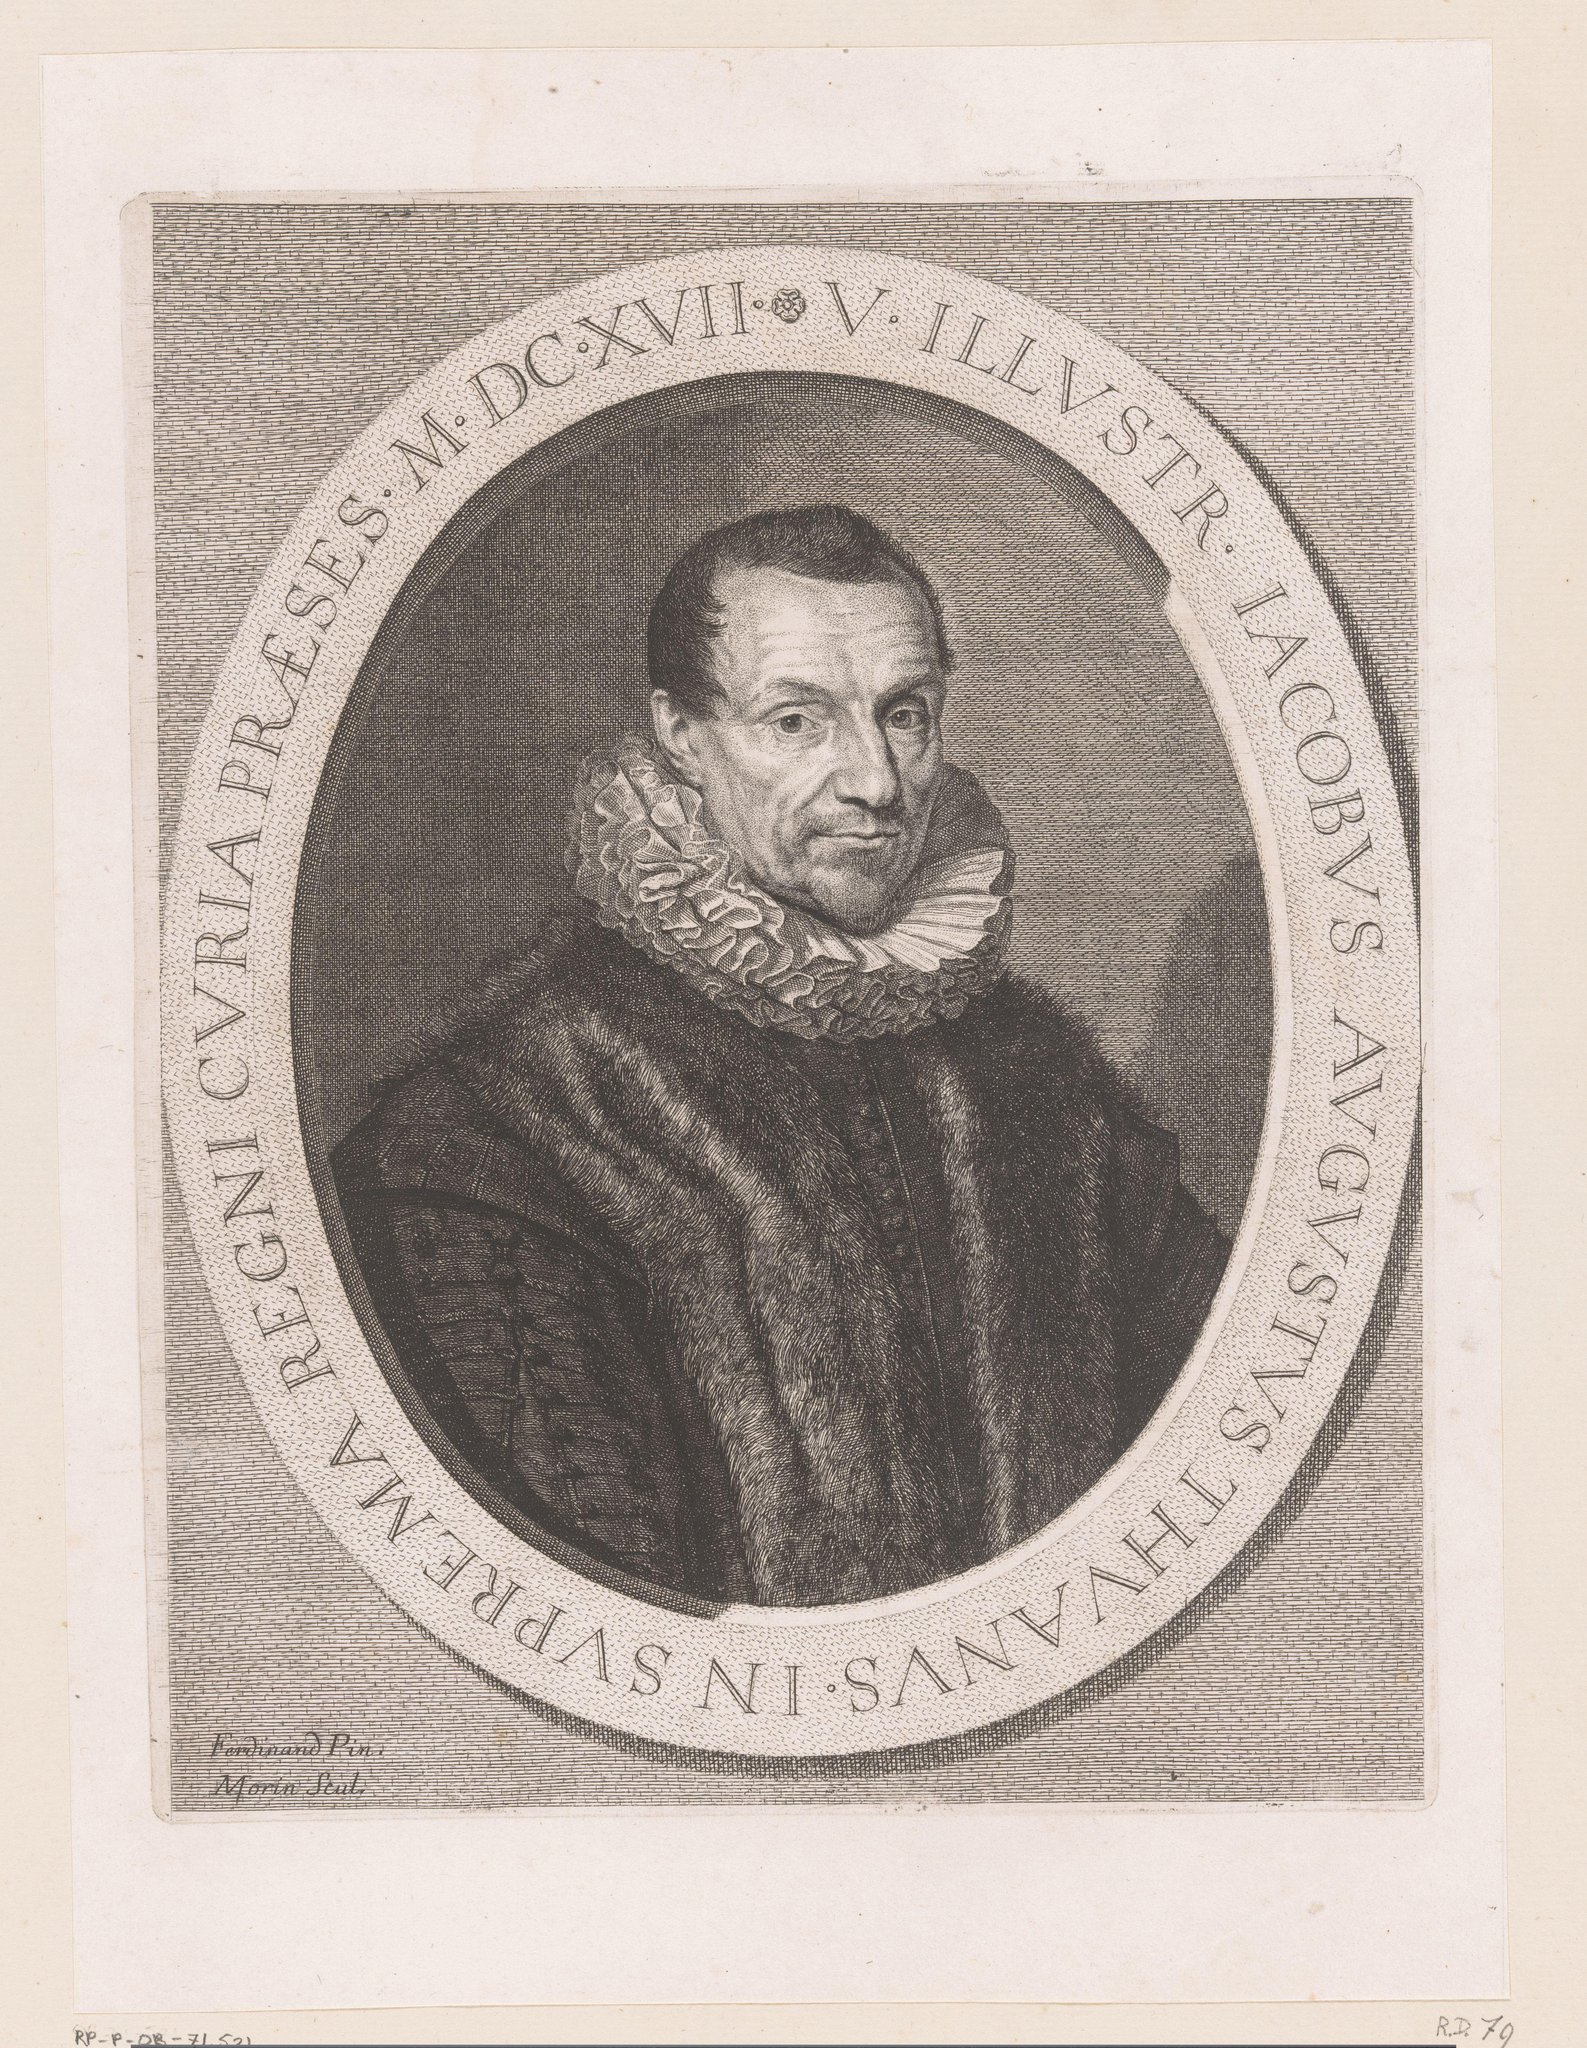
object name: print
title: Portret van Jacques-Auguste de Thou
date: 1640-1650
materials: paper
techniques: etching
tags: paris, politician, historical persons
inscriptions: collector's mark: Lugt 2228